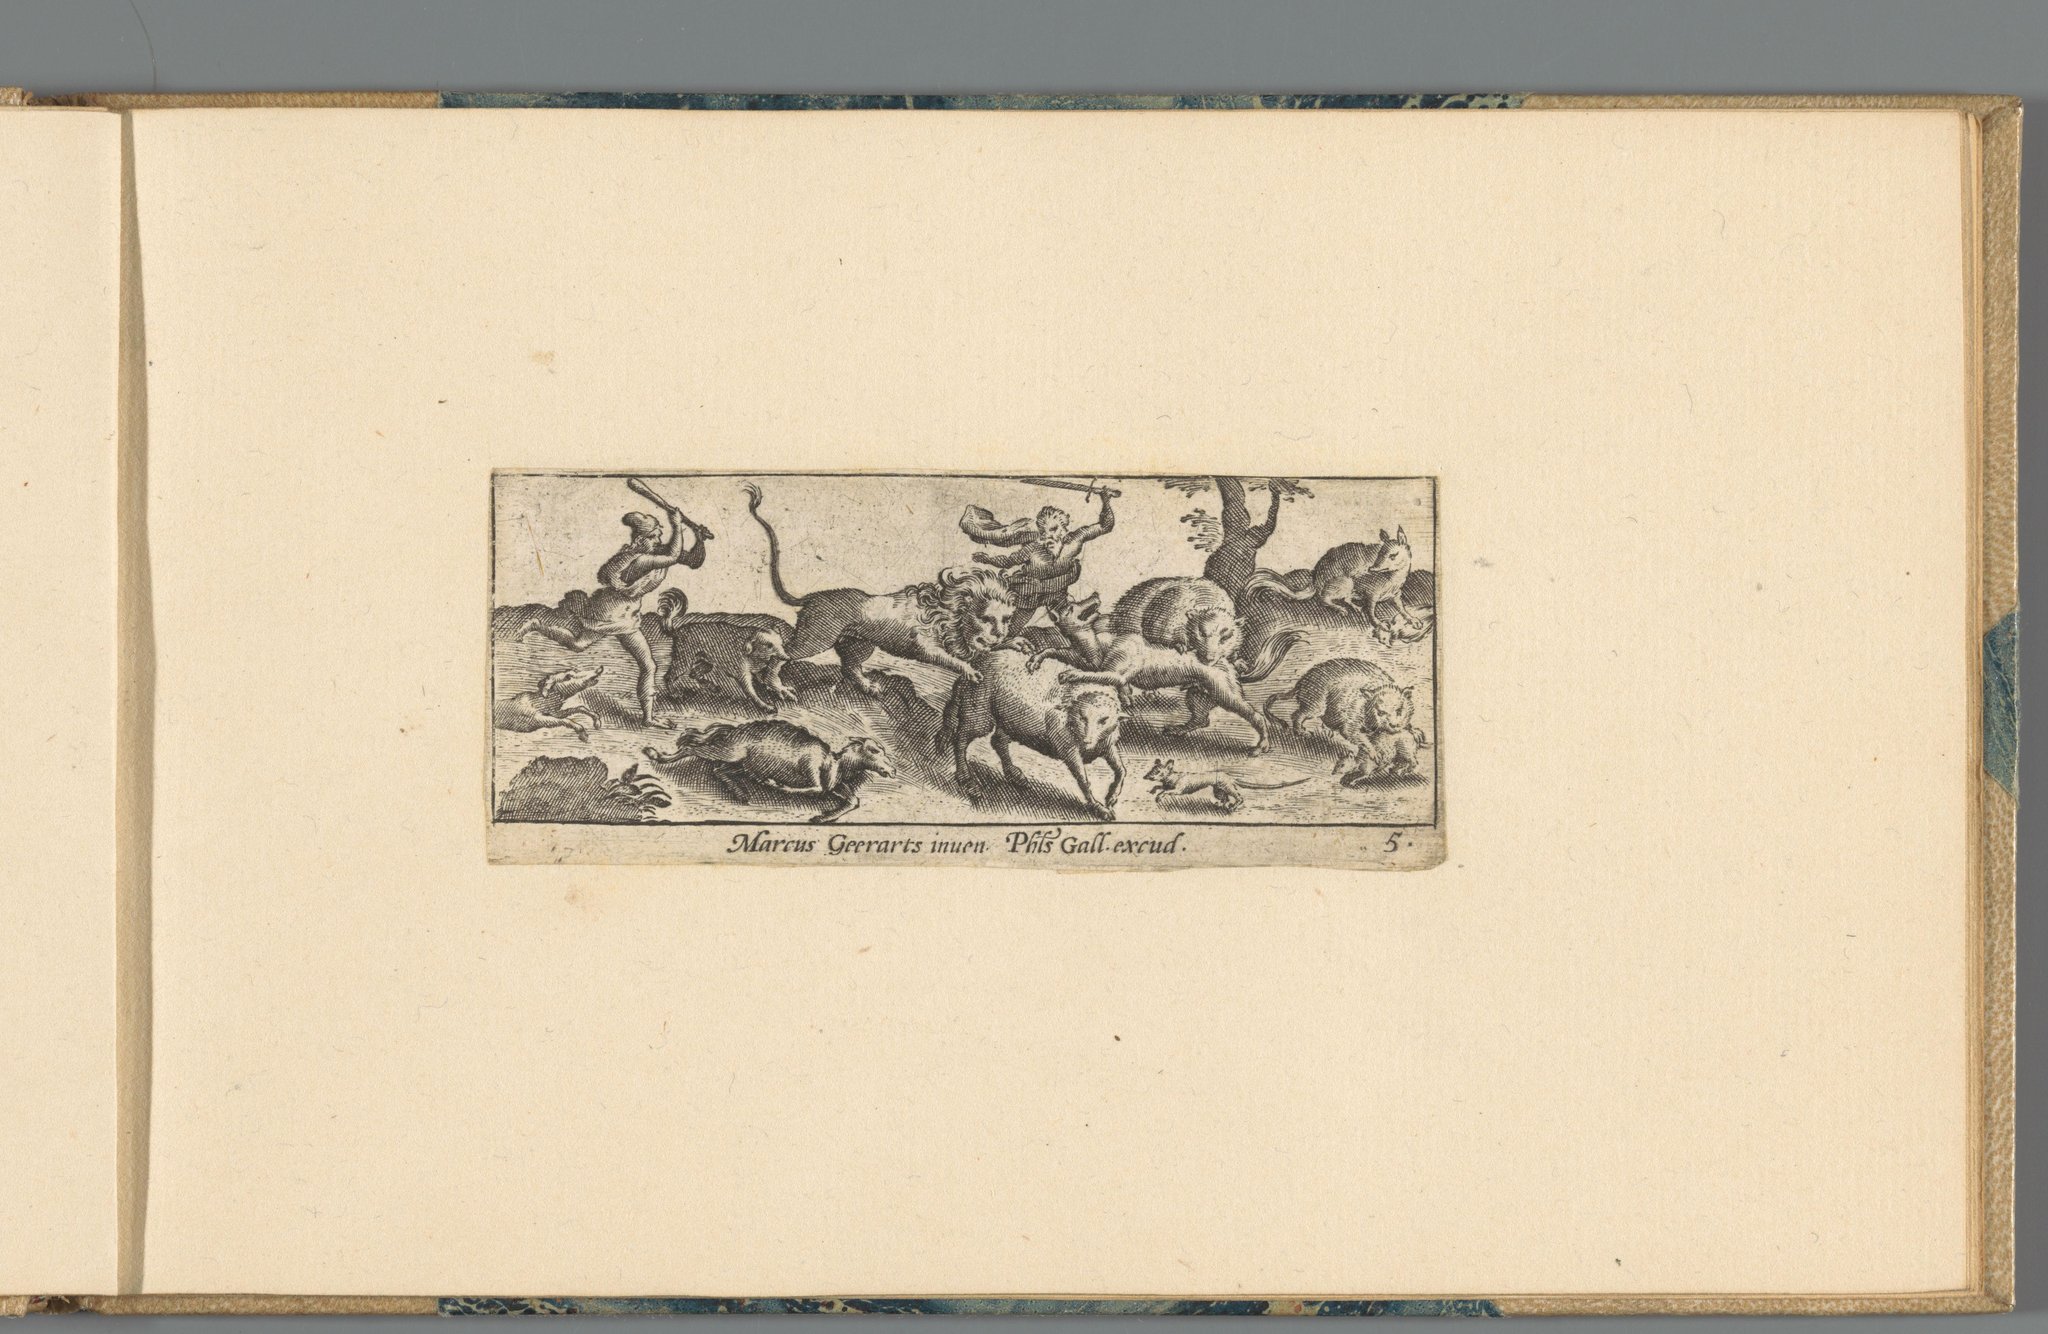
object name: album leaf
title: Jagers en jagende dieren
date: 1570-1612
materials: paper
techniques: engraving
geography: antwerp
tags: game, hunted animals, beasts of prey, predatory animals: bear, beasts of prey, predatory animals: lion, cat and mouse, beasts of prey, predatory animals: wolf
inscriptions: collector's mark: Lugt 2228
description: Landschap met twee jagers, de een met knuppel, de ander met zwaard. Een leeuw en een wolf vallen een schaap aan. De wolf wordt door een beer aangevallen. Rechts een vos met een vogel en een kat met een muis. Deze prent maakt deel uit van een album.